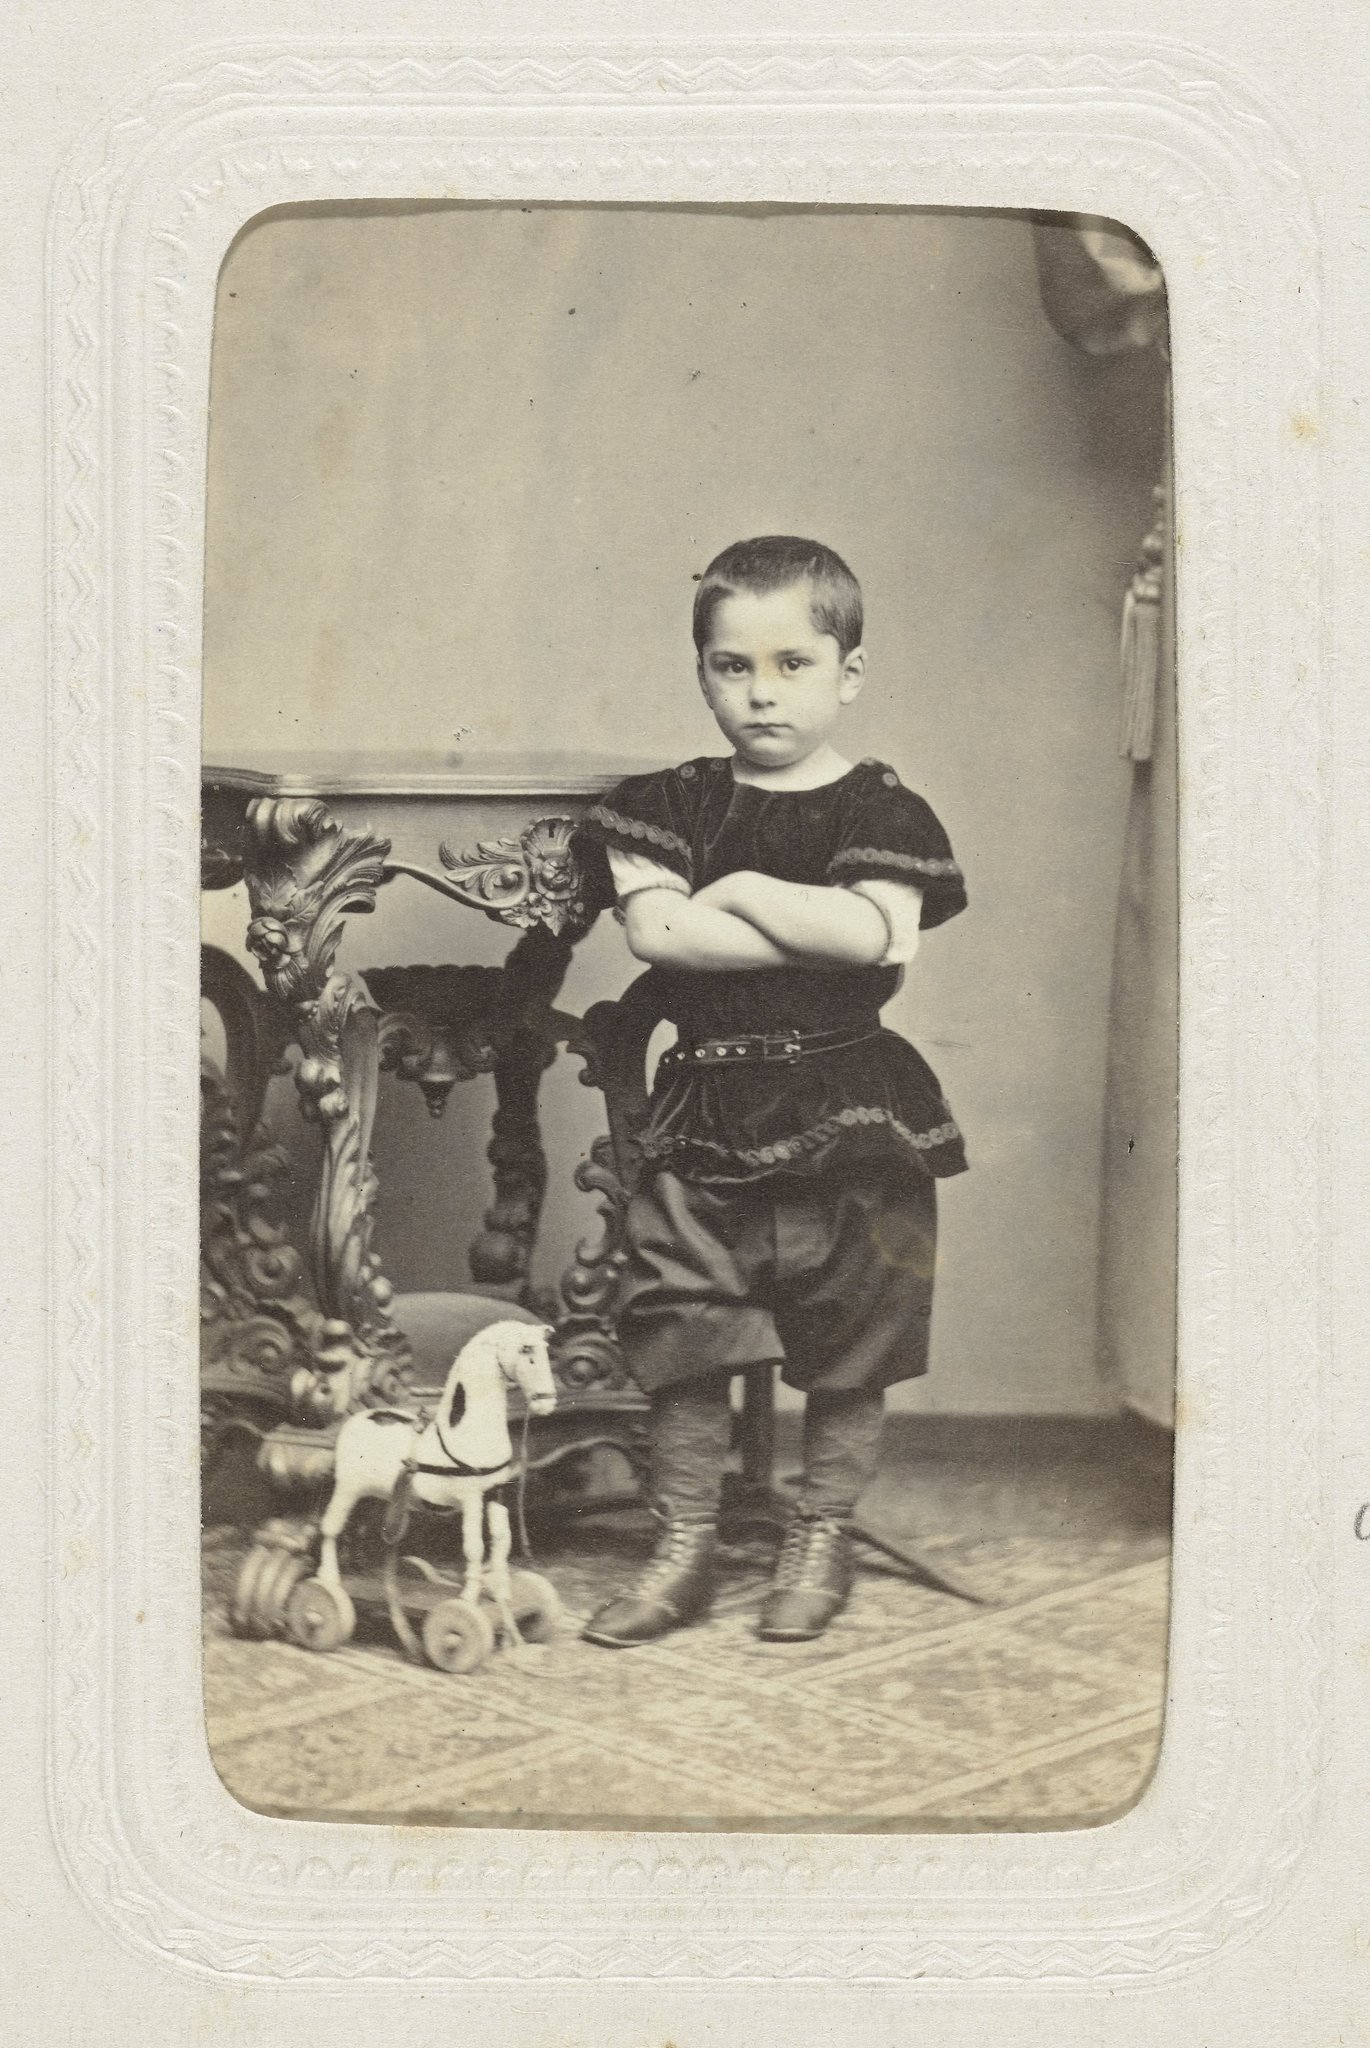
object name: carte de visite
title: Studioportret van een jongetje met een houten paard bij een tafel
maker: carl rensing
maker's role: fotograaf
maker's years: 1826-1898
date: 1863-1866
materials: cardboard, paper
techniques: albumen print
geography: amsterdam